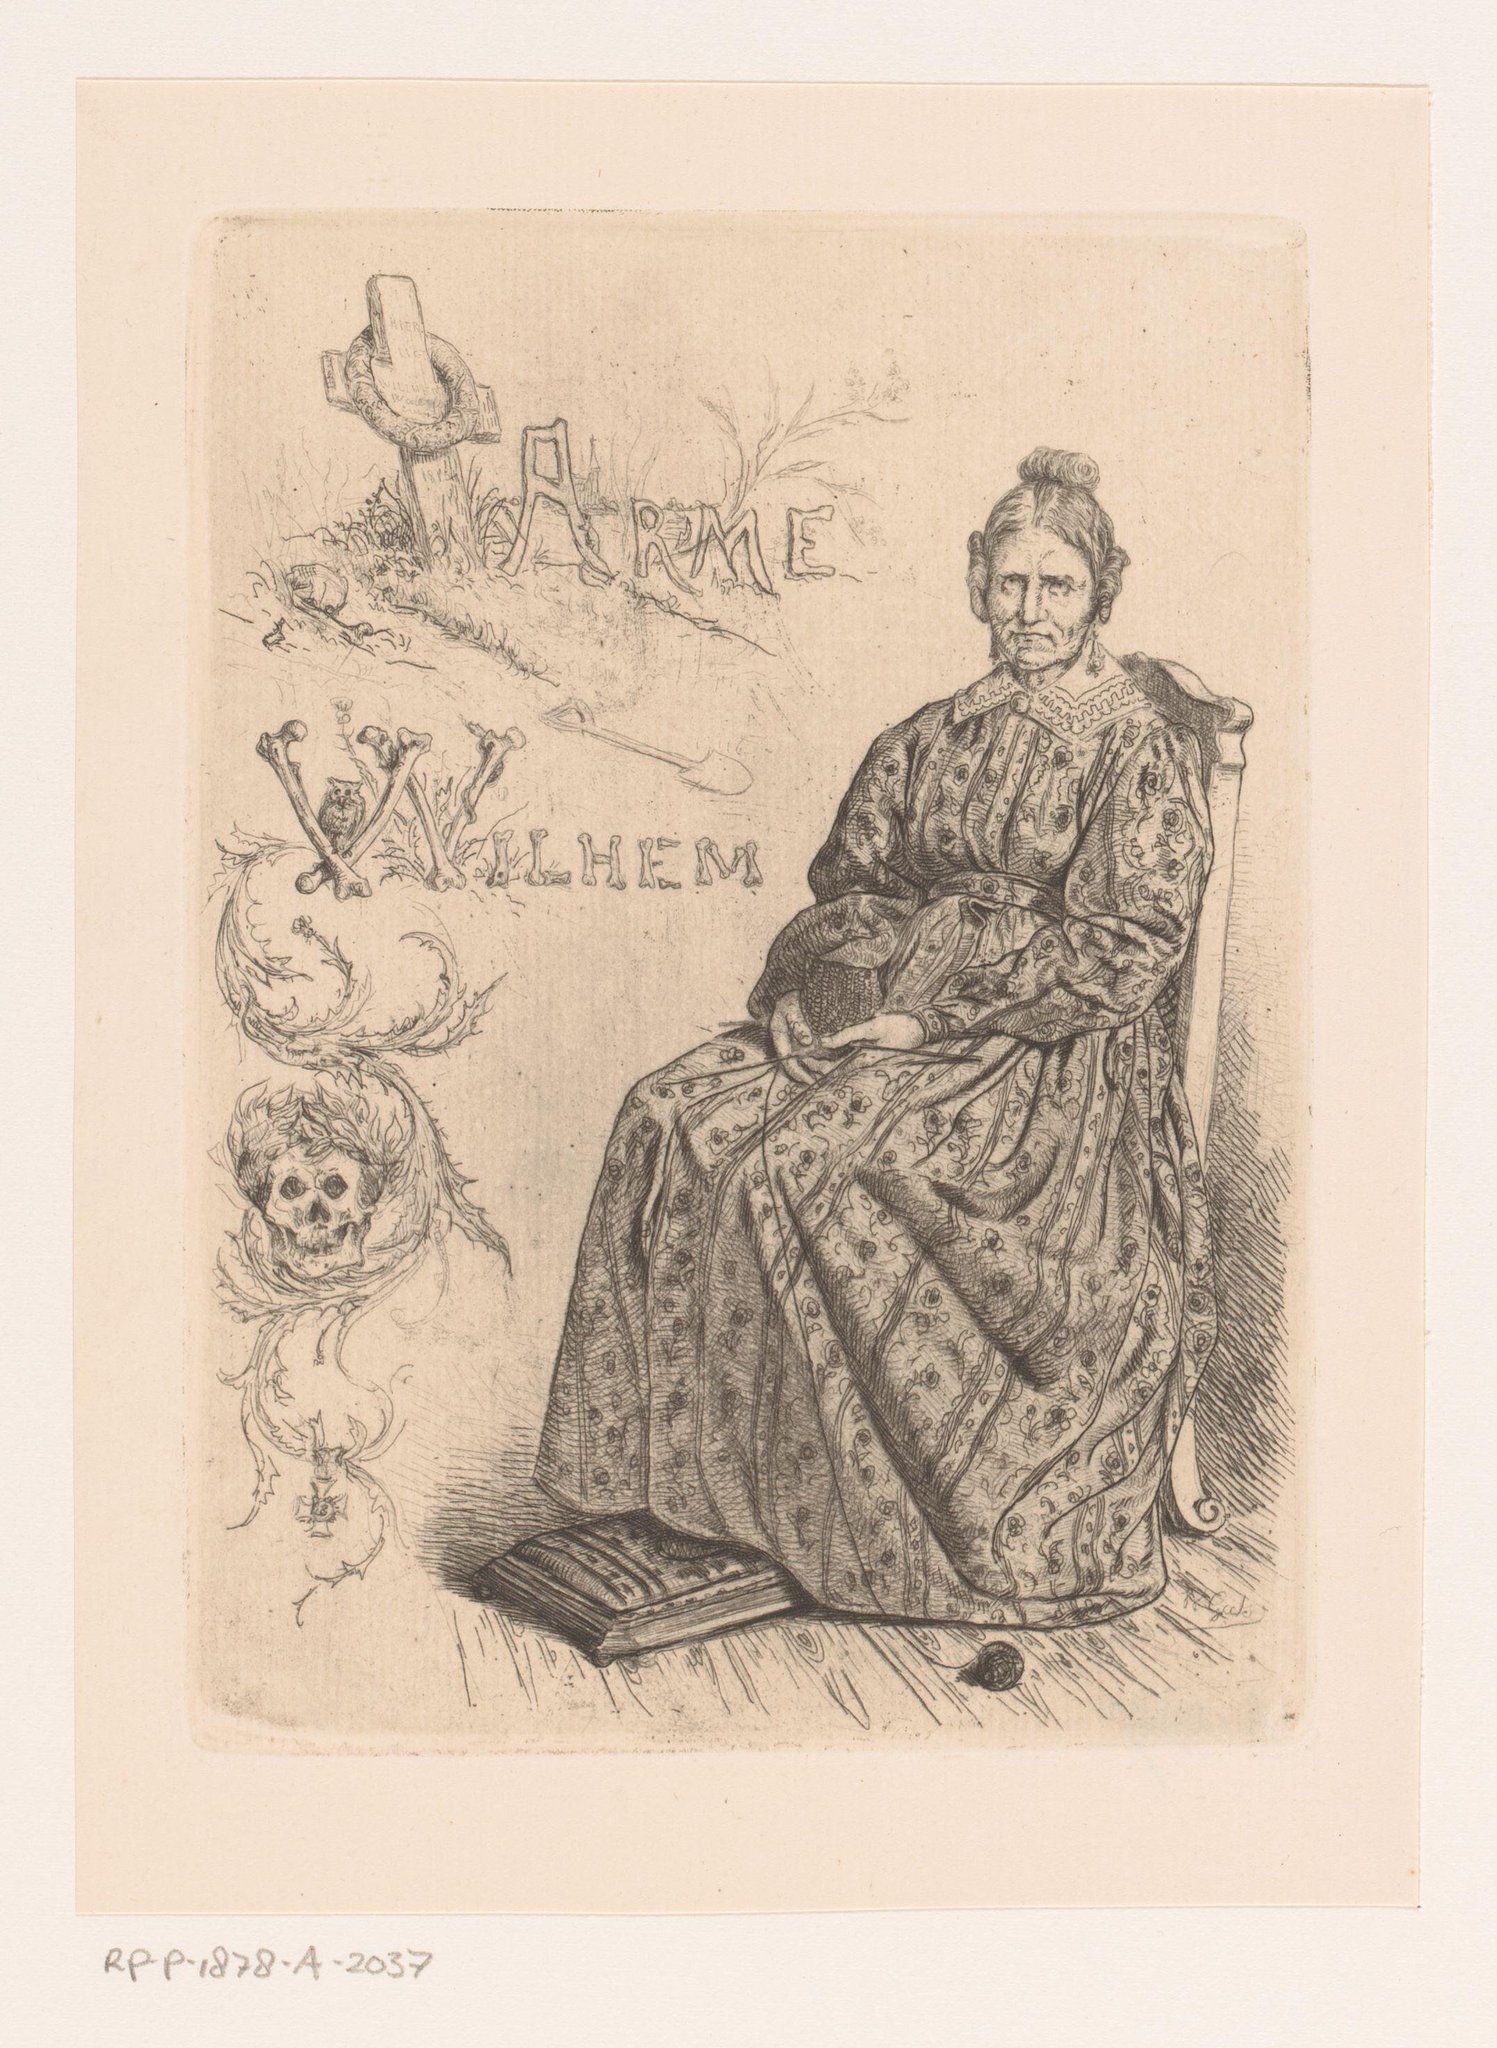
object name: print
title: Vrouw met breiwerk op een stoel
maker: willem geets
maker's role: print maker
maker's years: 1838-1919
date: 1874-1875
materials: paper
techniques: etching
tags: sitting figure - aa - female human figure, skull as symbol of 'vanitas', gravestone, tombstone, knitting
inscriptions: collector's mark: Lugt 2228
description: Prent uit: Bergmann, Anton. Ernest Staas, advocaat: schetsen en beelden. Gent: Hoste, Den Haag: Martinus Nijhoff, [1874-1875].